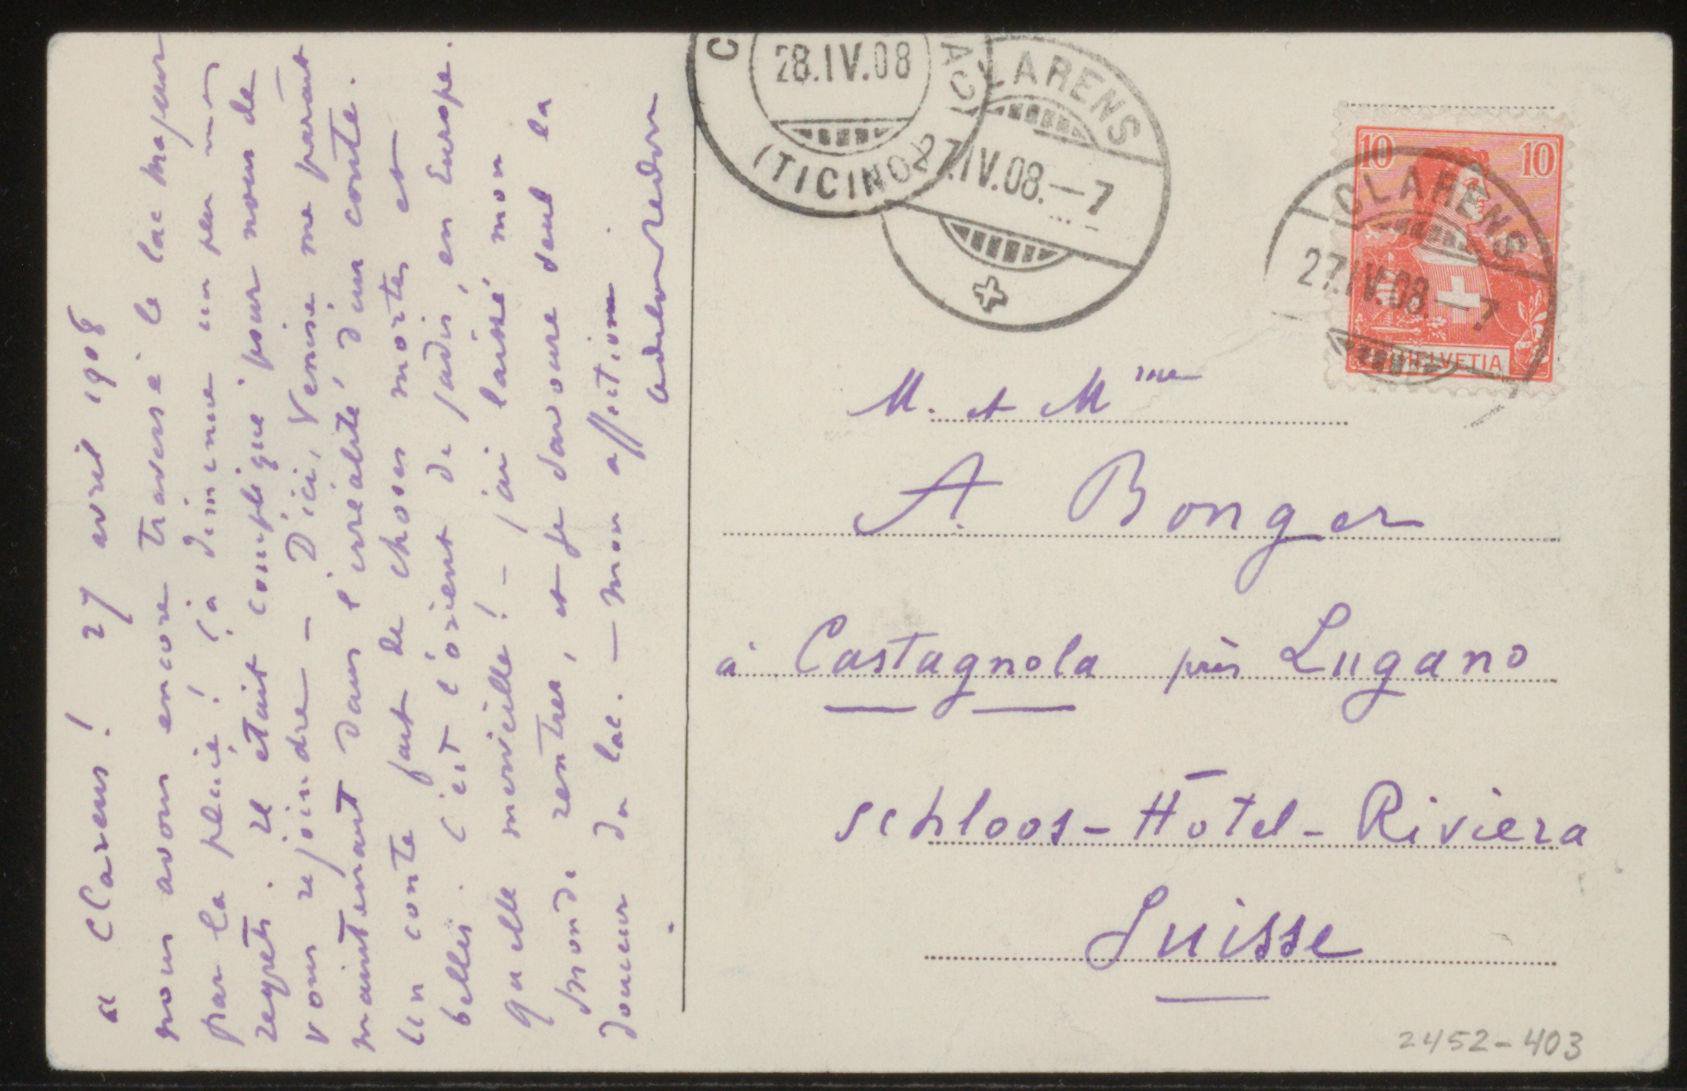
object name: ansichtkaart, prentbriefkaart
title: Prentbriefkaart aan Andries Bonger en Anne Marie Louise van der Linden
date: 1908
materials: cardboard, ink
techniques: photograph, pen, writing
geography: clarens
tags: andries bonger, travelling; tourism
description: Prentbriefkaart behoort tot een album samengesteld door weduwe Françoise W.M. Barones van der Borch van Verwolde met afschriften van brieven met betrekking tot (de familie van) Odilon Redon. De prentbriefkaart werd bewaard op pagina 144.